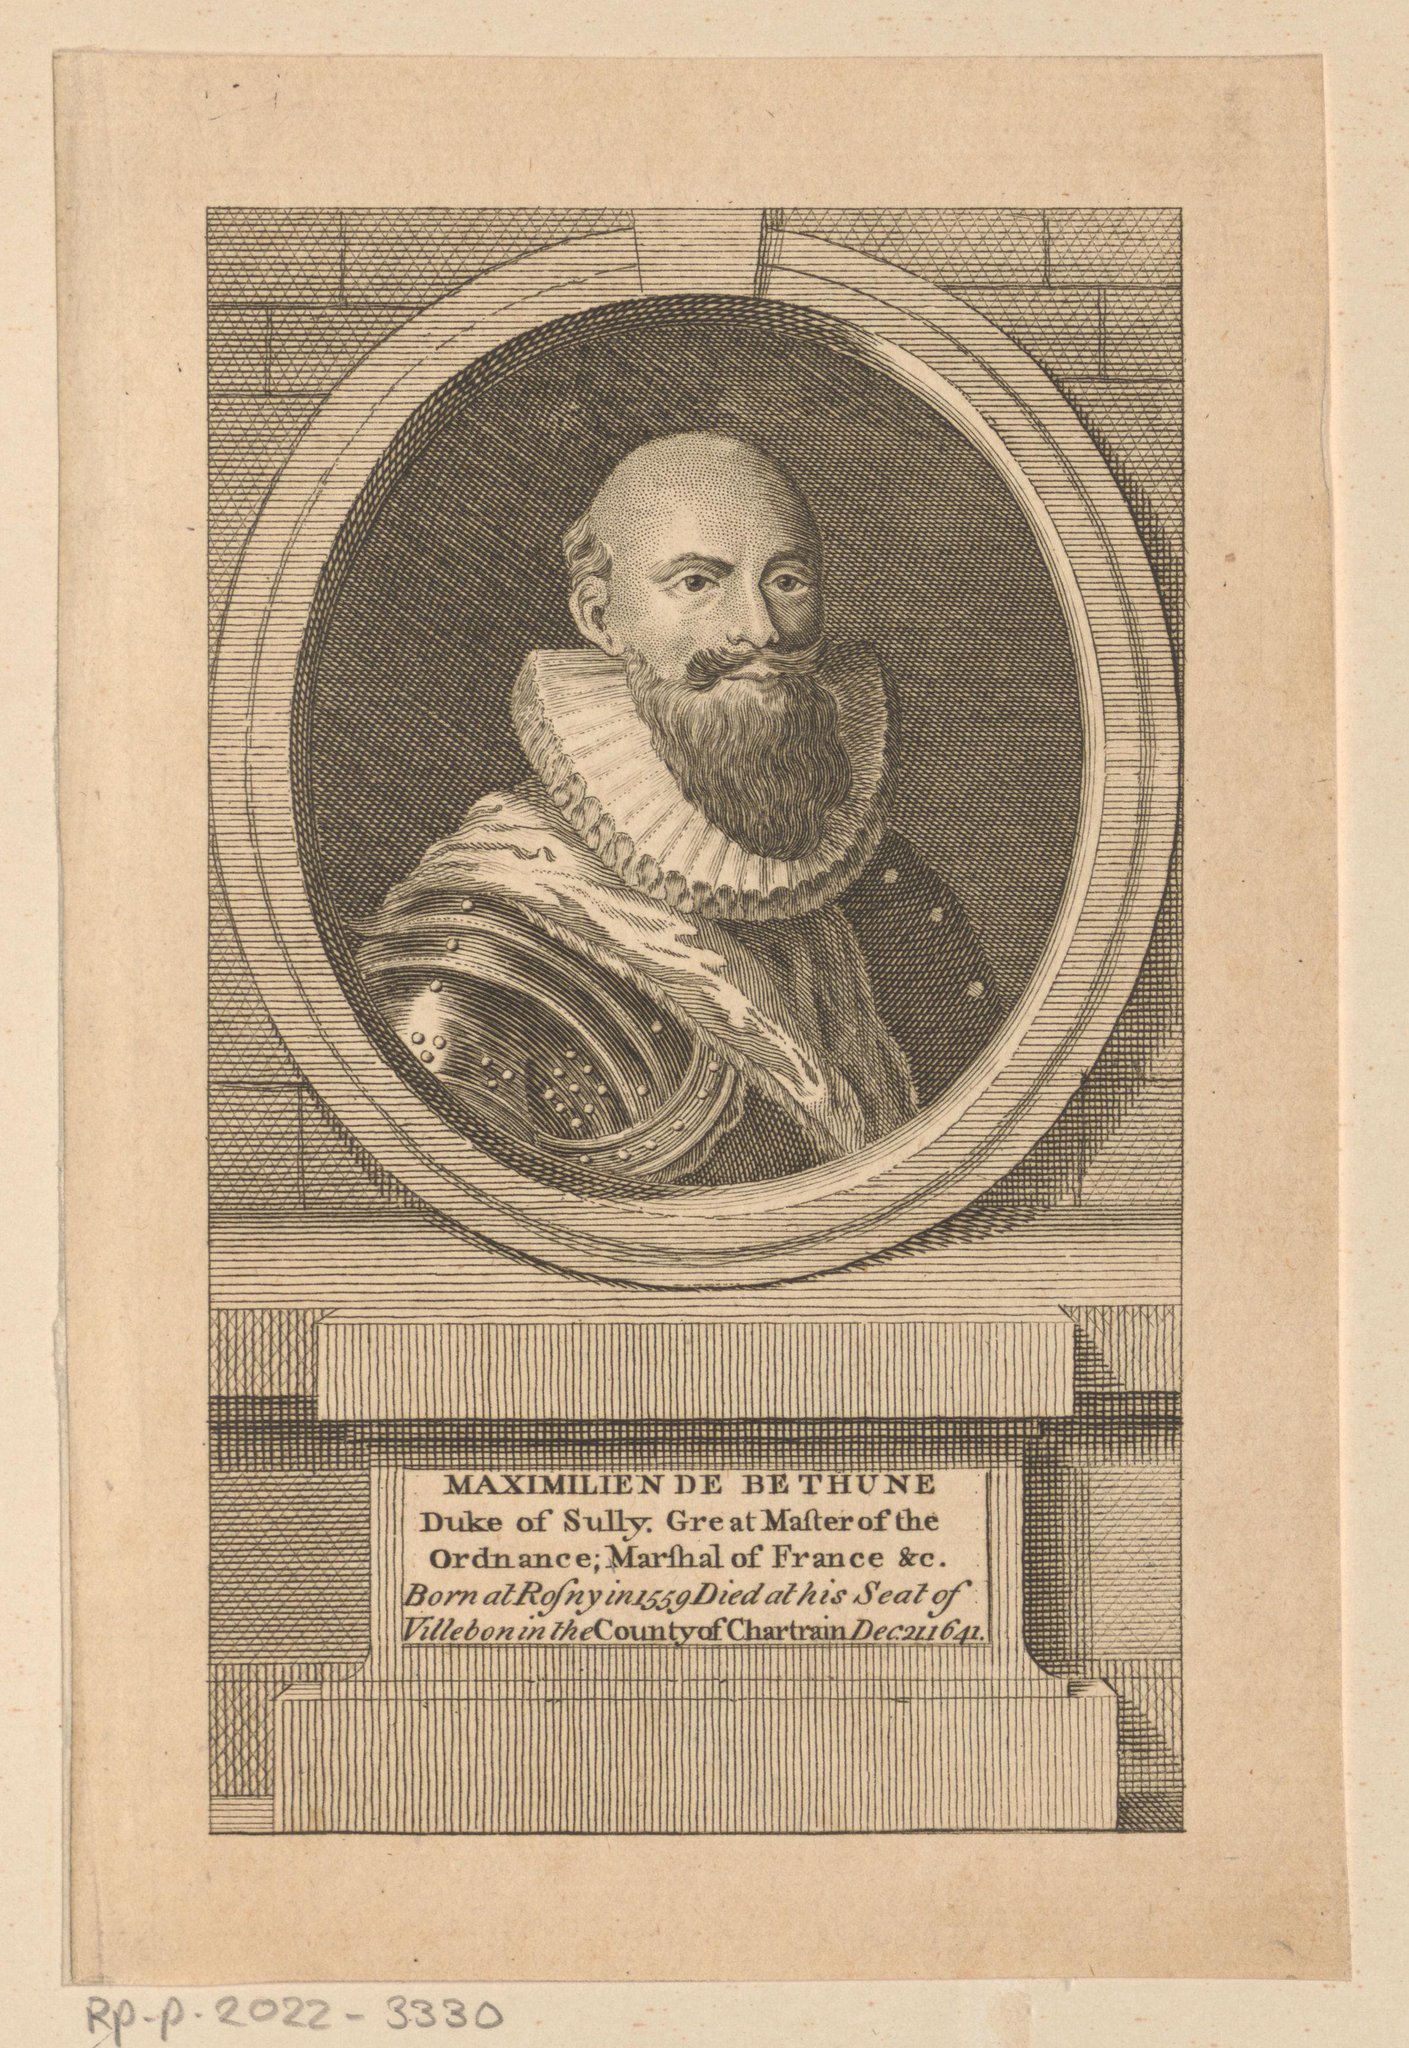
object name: print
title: Portret van Maximilien de Béthune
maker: Anonymous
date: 1750-1800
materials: paper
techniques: engraving, etching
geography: england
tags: maximilien de béthune (duke of sully), armour, historical persons